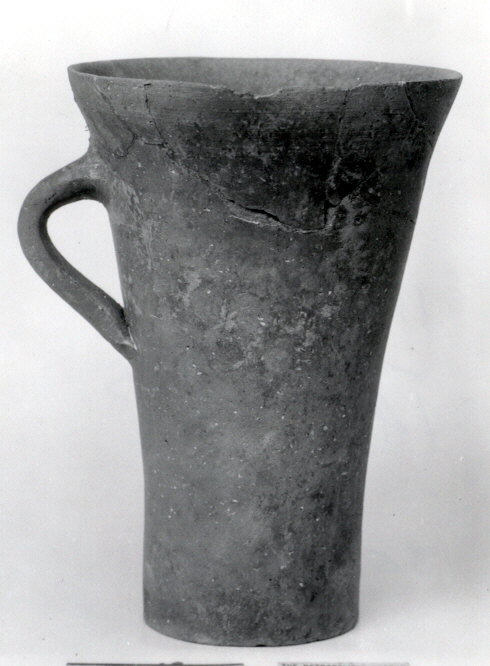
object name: jug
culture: iranian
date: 333-1 BCE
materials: ceramic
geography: iran